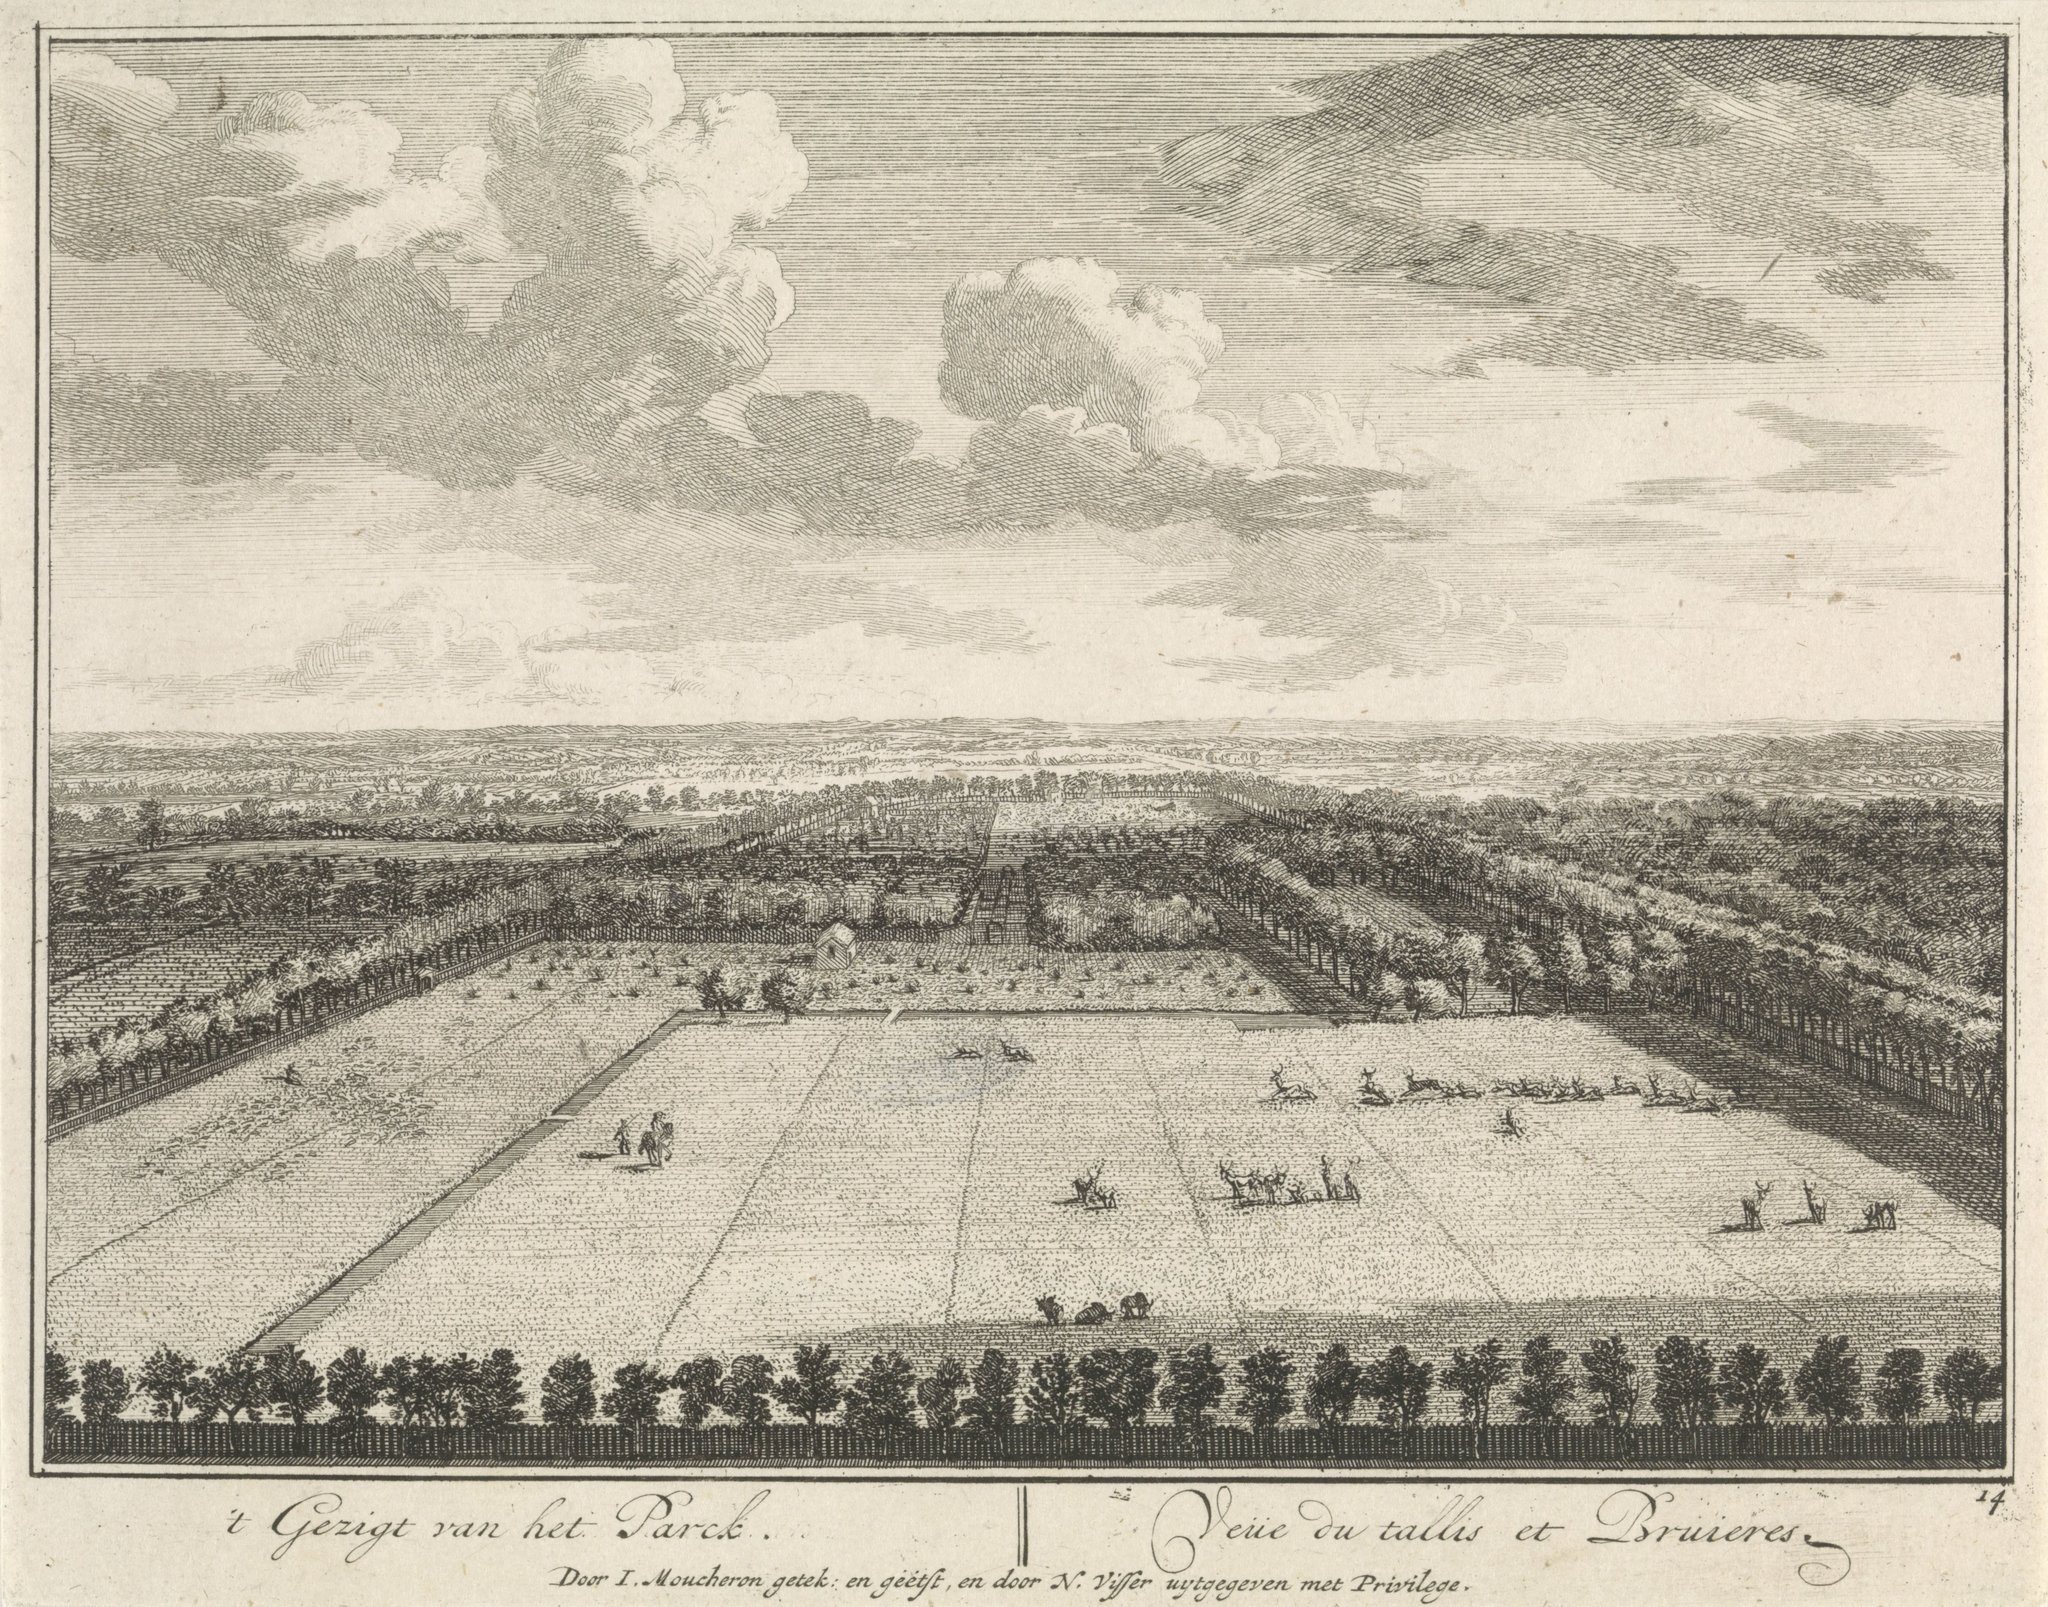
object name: print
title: 't Gezigt van het Parck / Veüe du tallis et Bruieres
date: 1706-1719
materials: paper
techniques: engraving, etching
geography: amsterdam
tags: bird's eye view ~ architectural design or model, public gardens, park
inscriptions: collector's mark: Lugt 2760, collector's mark: Lugt 2228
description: De landerijen bij Kasteel Heemstede gezien vanuit vogelvlucht perspectief. In de weilanden staan roedels herten.